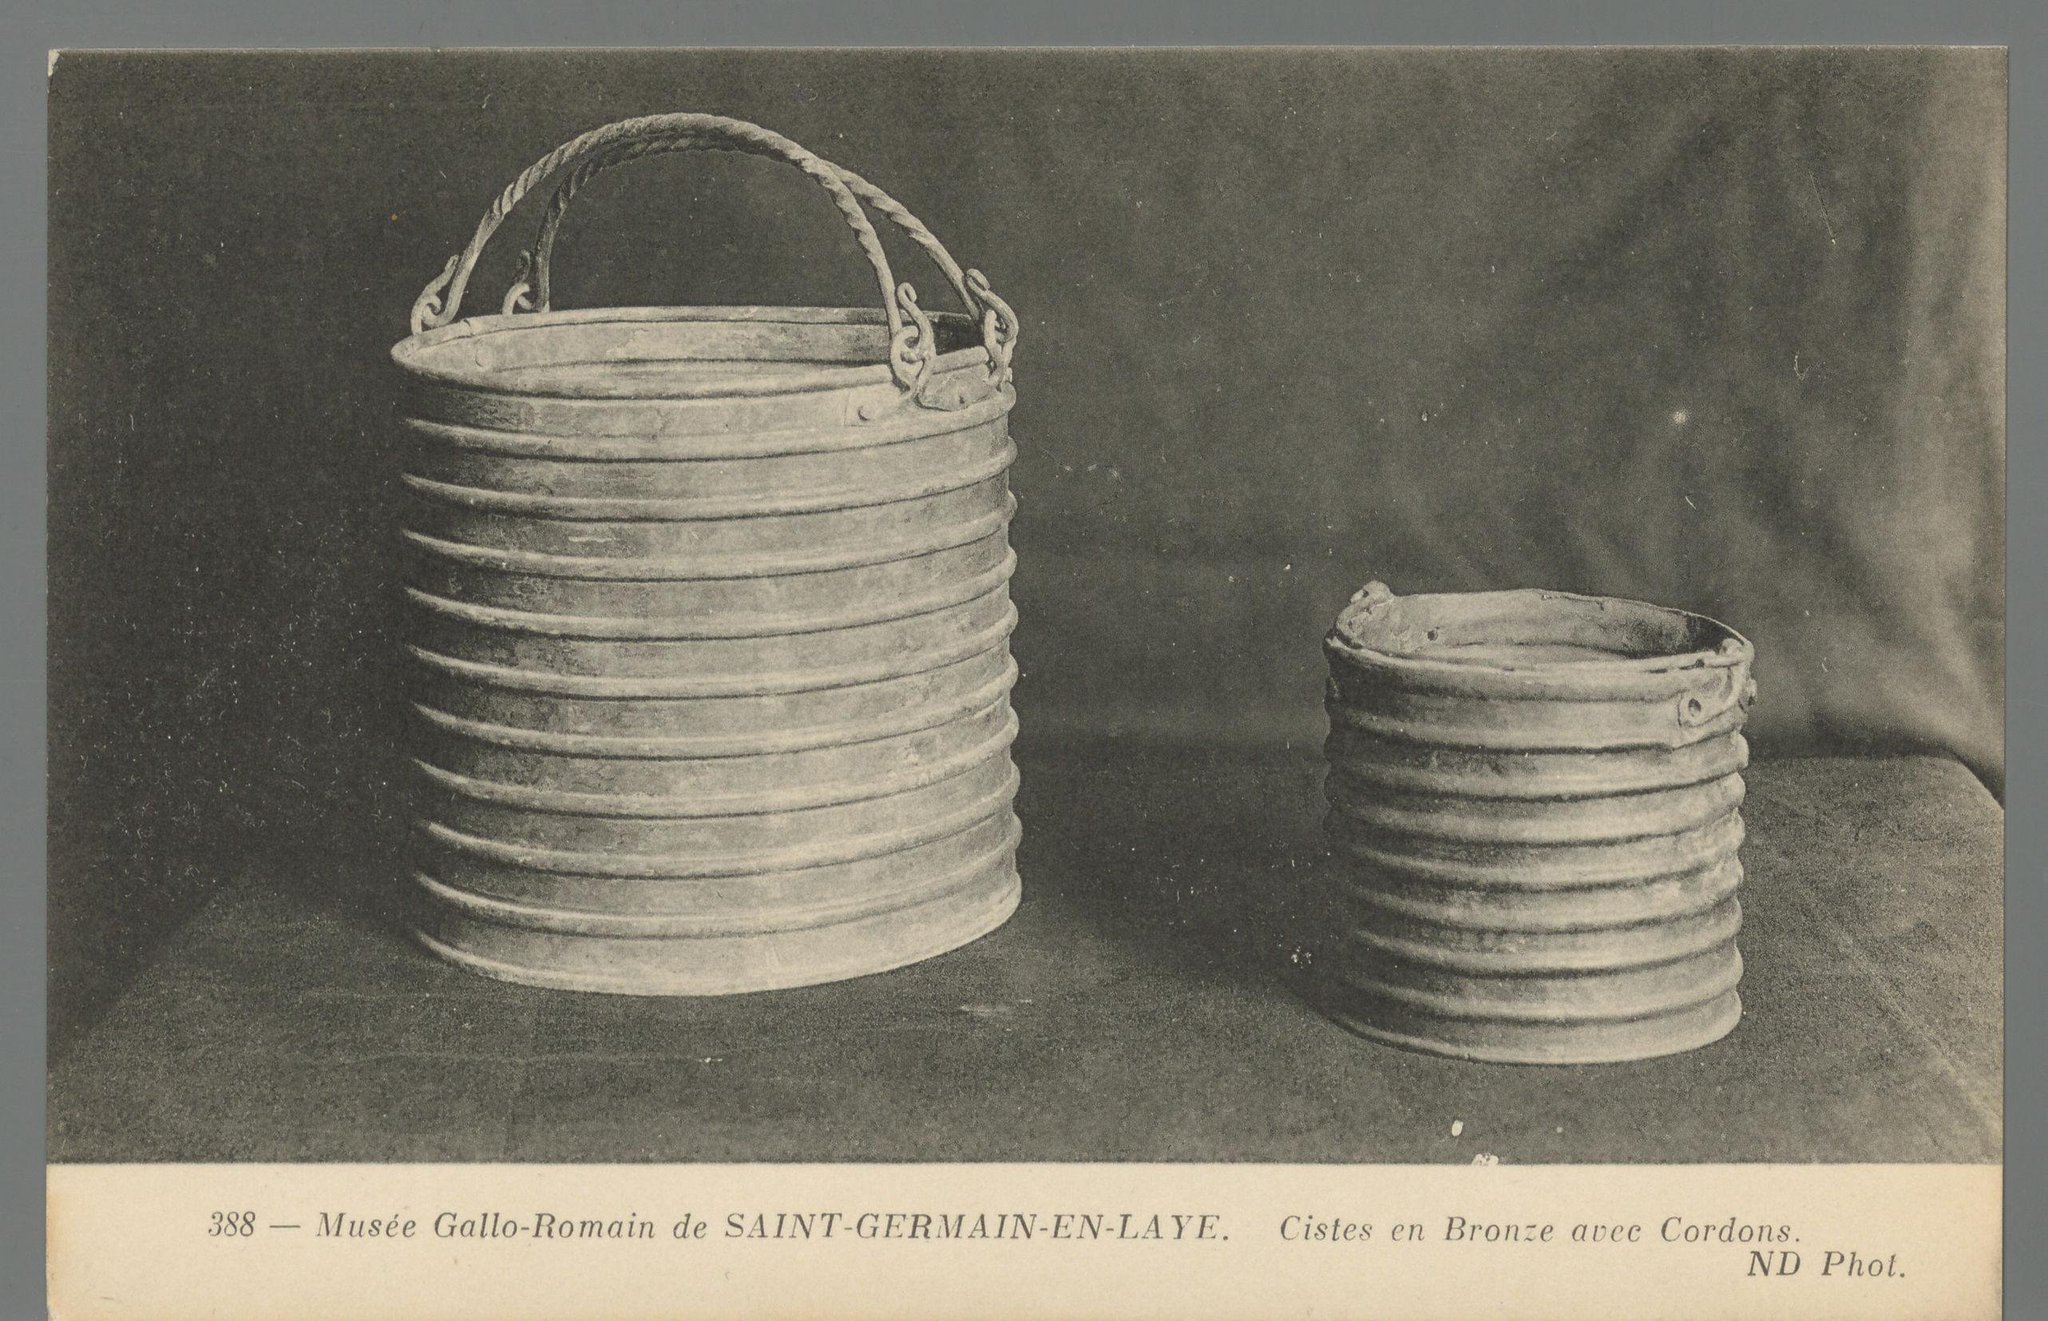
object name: ansichtkaart, prentbriefkaart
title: Musée Gallo-Romain de Saint-Germain-en-Laye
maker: Anonymous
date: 1903-1918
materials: cardboard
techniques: photograph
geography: paris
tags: permanent exhibition, museum, container of metal: bucket, can, canister, drum, tin